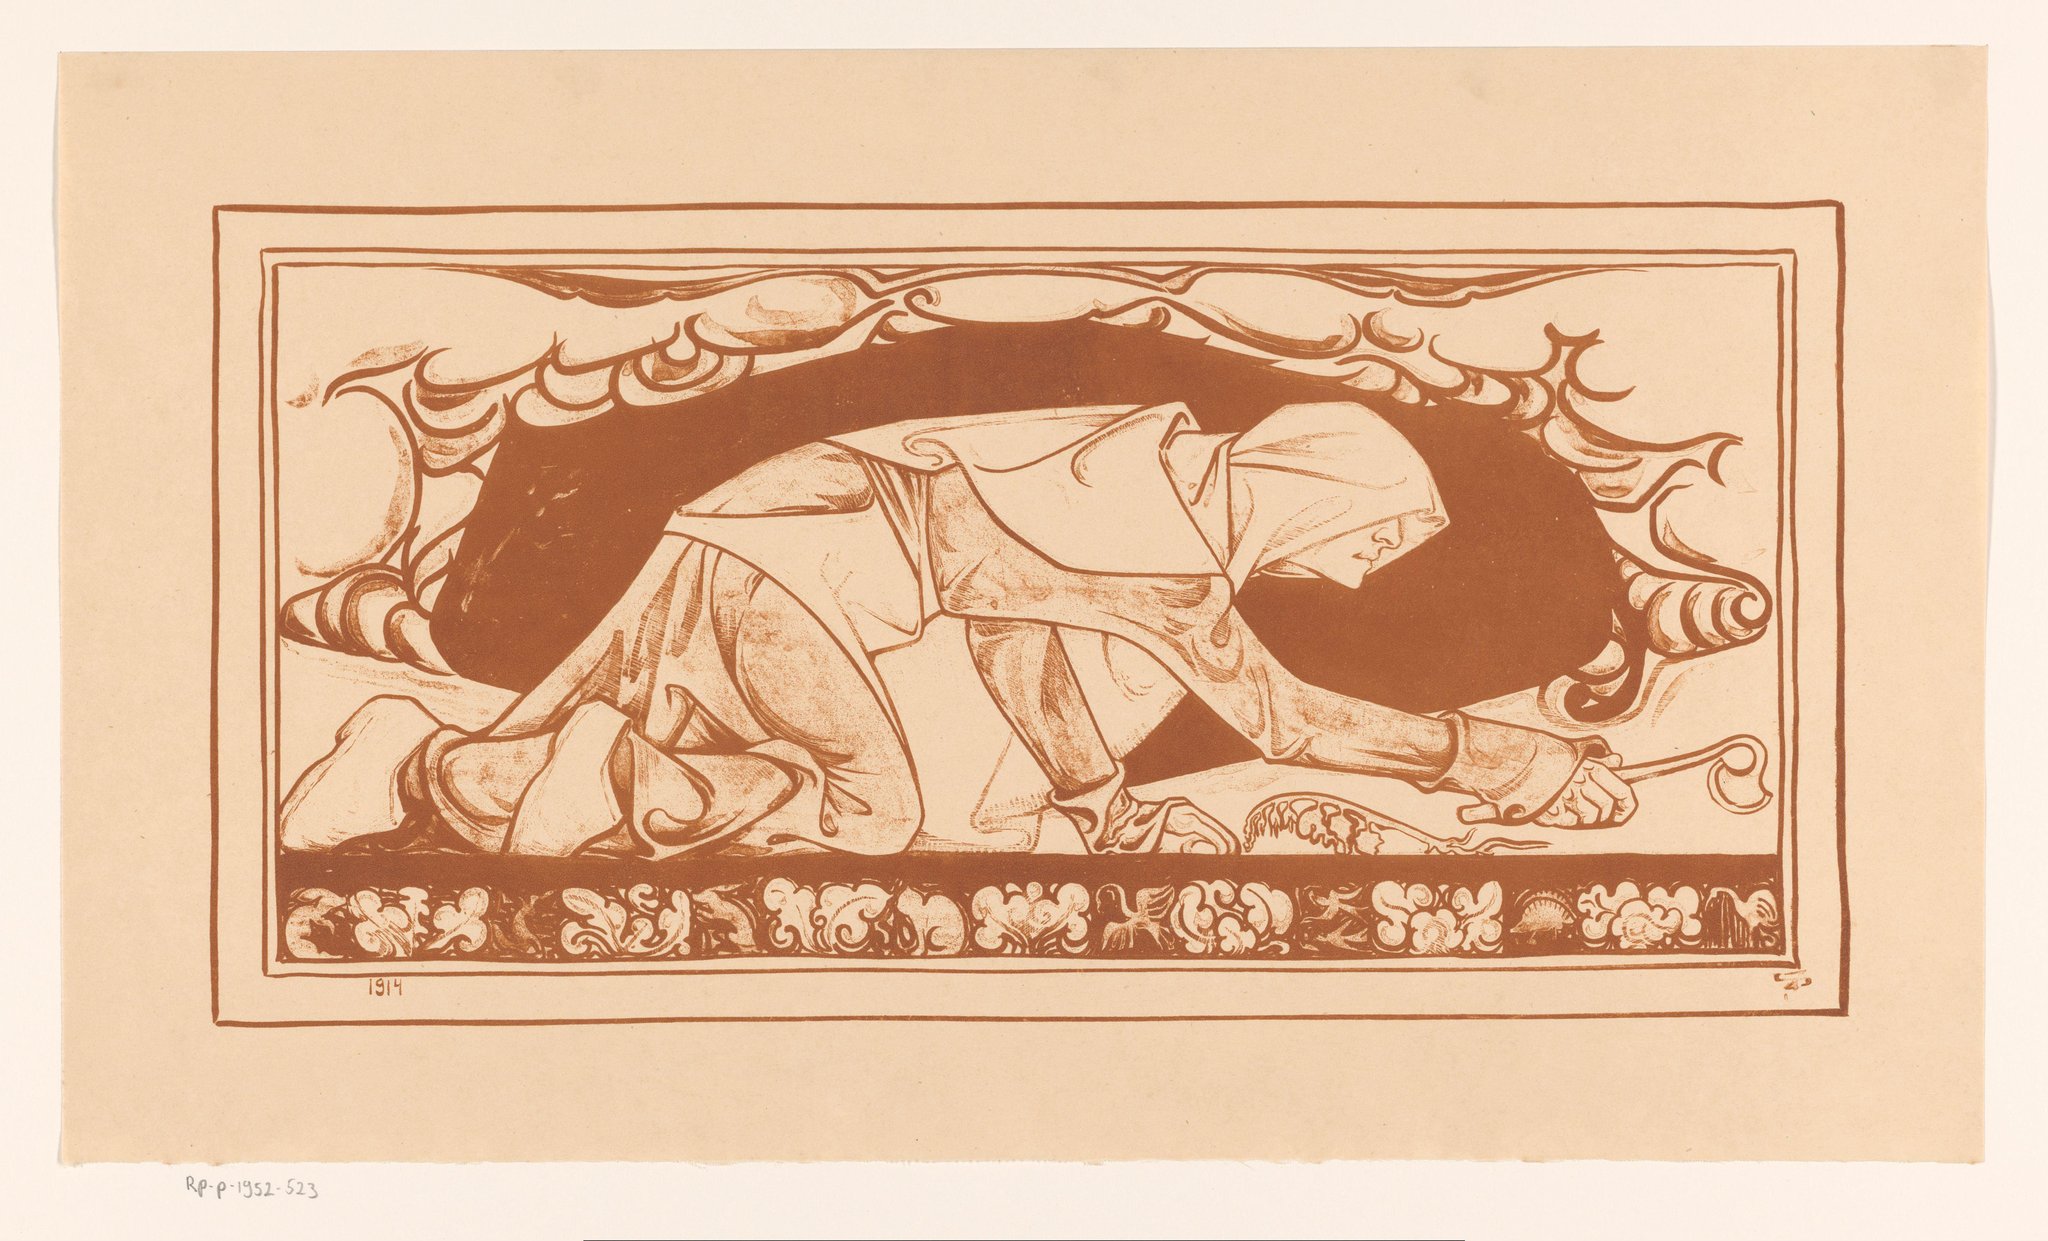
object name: print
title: Man in monnikspij kruipend met schoffel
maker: jac jongert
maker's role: print maker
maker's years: 1883-1942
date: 1914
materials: paper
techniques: lithograph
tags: agricultural implements: hoe, monk(s), friar(s)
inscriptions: collector's mark: Lugt 2228